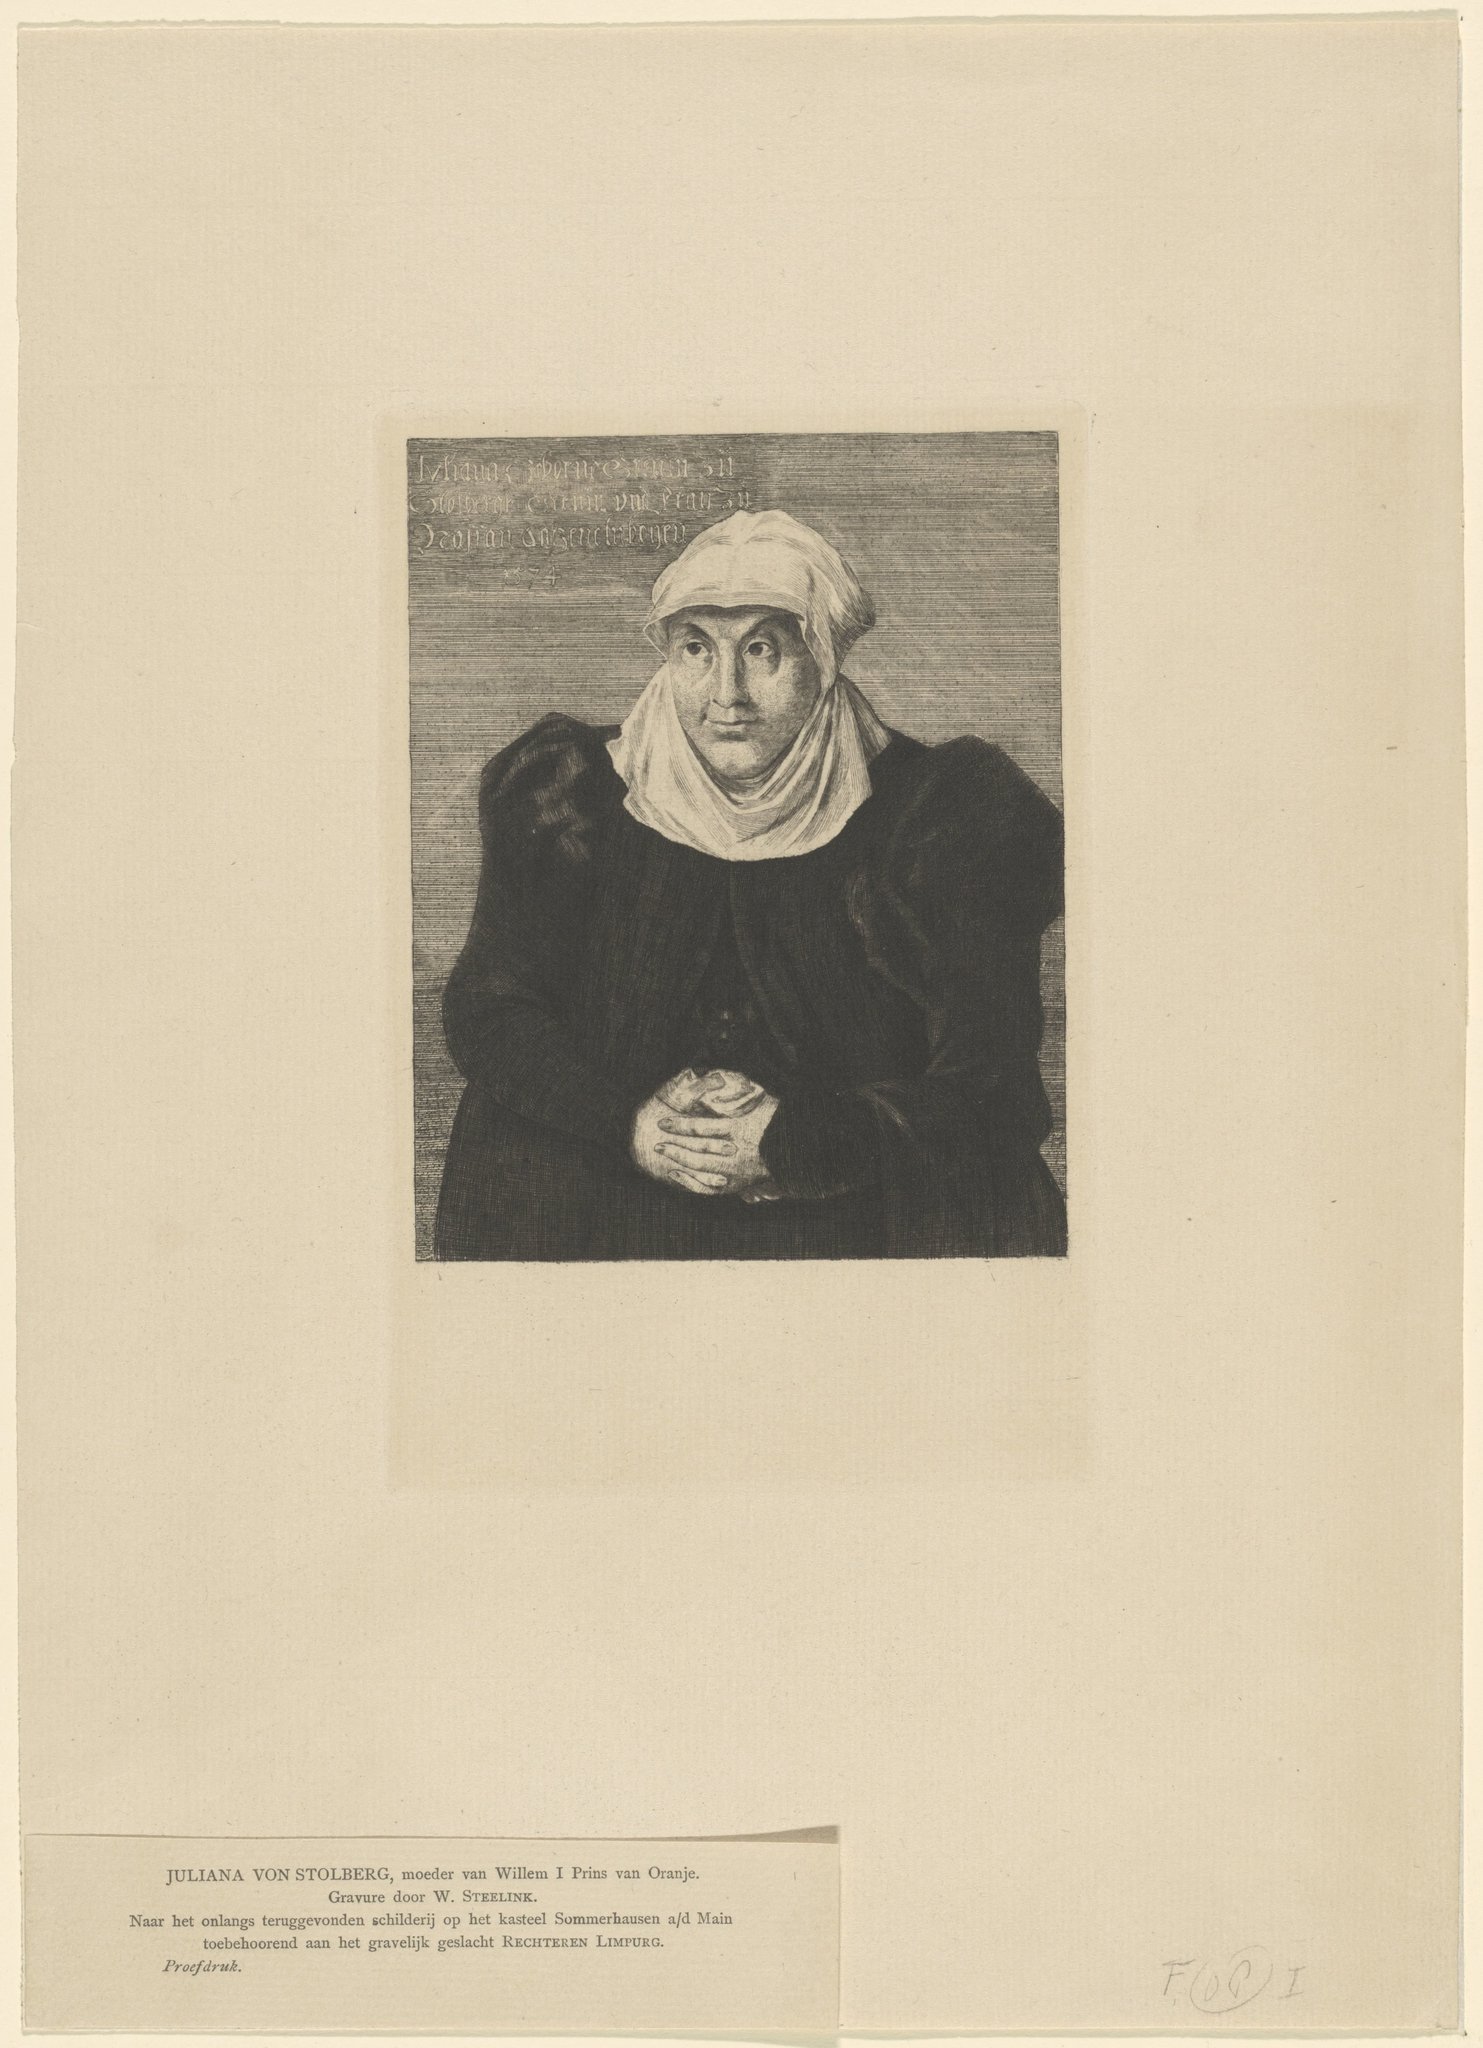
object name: print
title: Portret van Juliana van Stolberg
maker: willem steelink (i)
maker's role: draughtsman, print maker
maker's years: 1826-1913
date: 1841-1893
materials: paper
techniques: etching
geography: netherlands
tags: stolberg, dillenburg, juliana van stolberg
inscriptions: collector's mark: Lugt 2228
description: Portret van Juliana. Linksboven haar naam, haar titels en het jaartal '1574'.